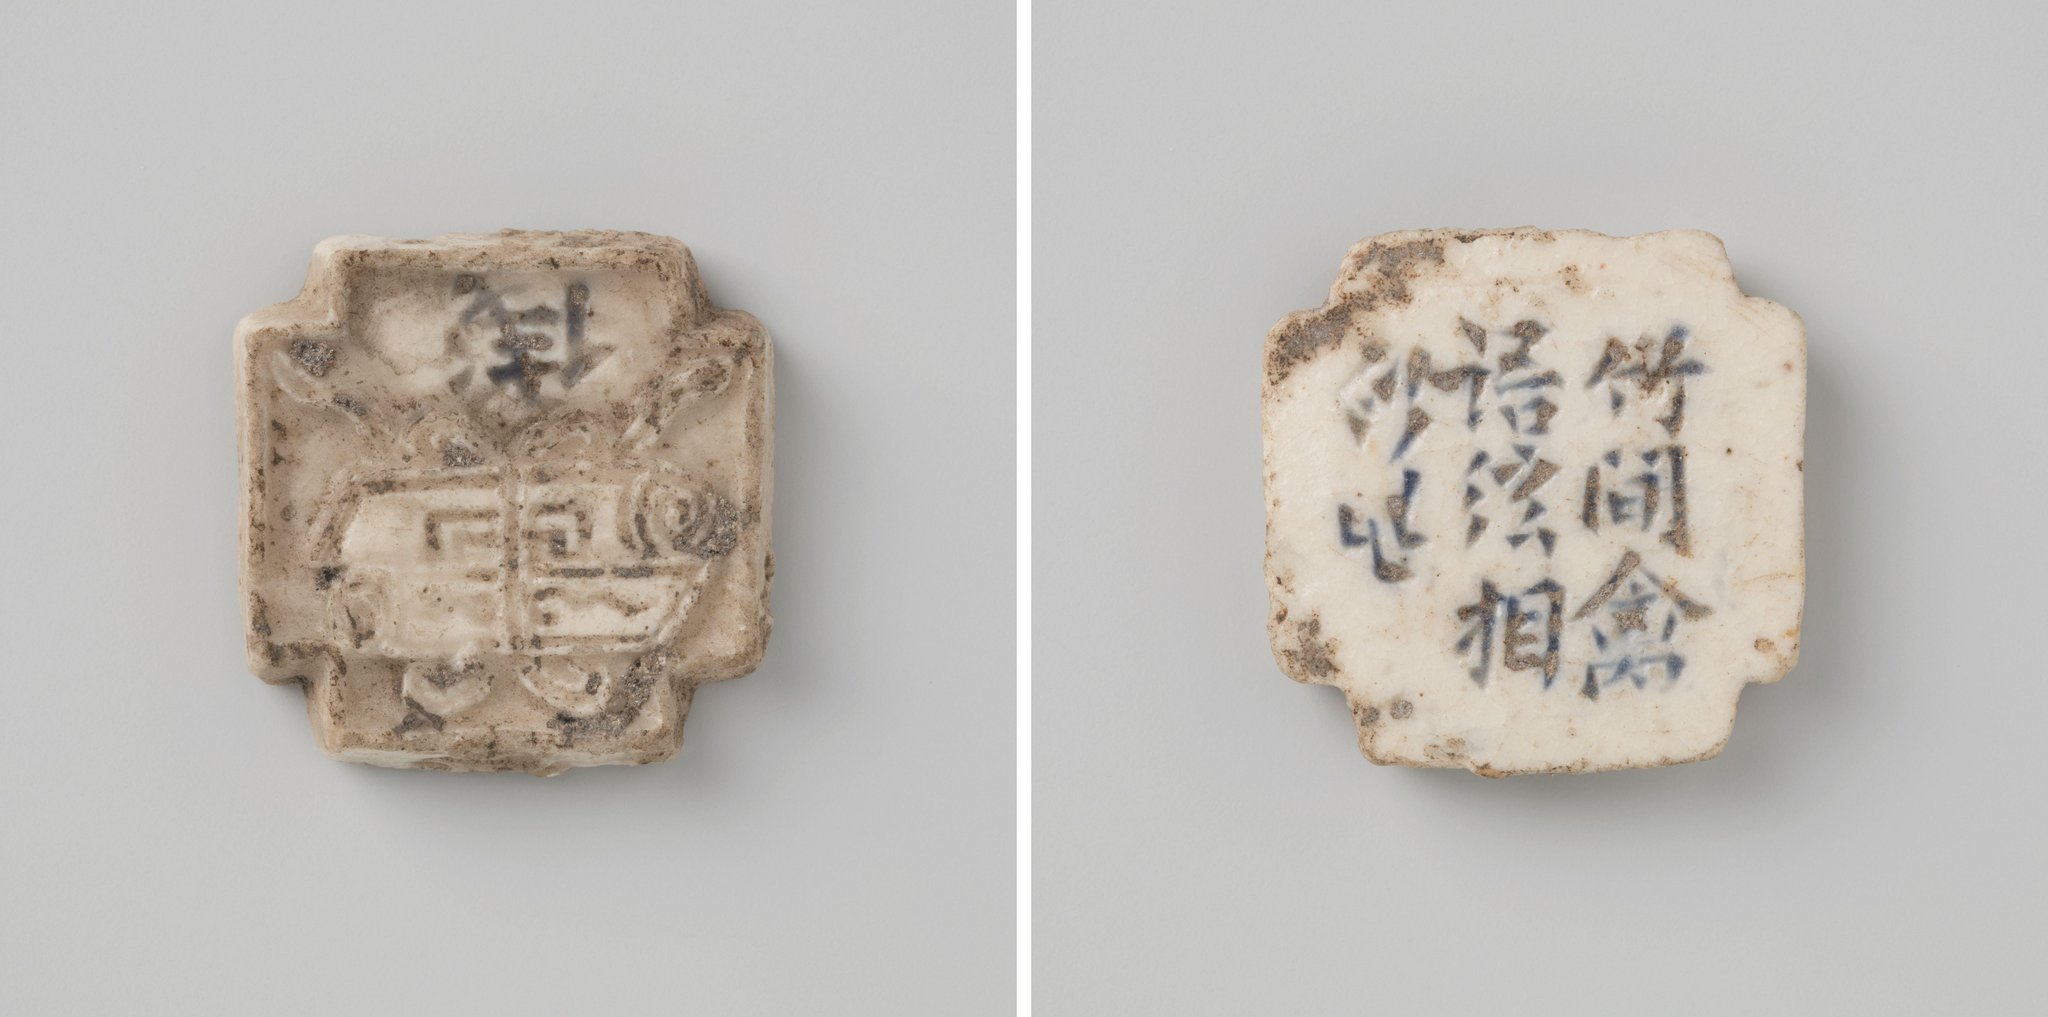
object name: coin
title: Speelhuispenning uit Thailand ter waarde van een salung, 1760-1871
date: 1760-1871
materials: porcelain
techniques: firing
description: Vierkanten porseleinen speelhuispenning in kruisvorm, die ook als munt is gebruikt. Voorzijde: afbeelding, waaronder een Chinese karakter. Keerzijde: acht Chinese karakters.